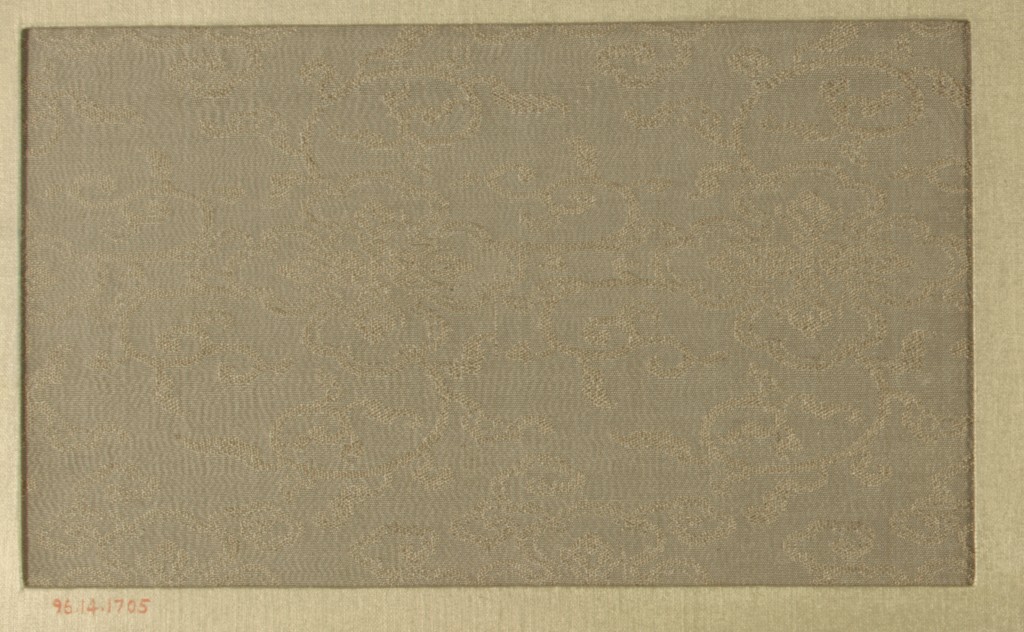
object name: piece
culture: japanese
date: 1701-1900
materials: silk